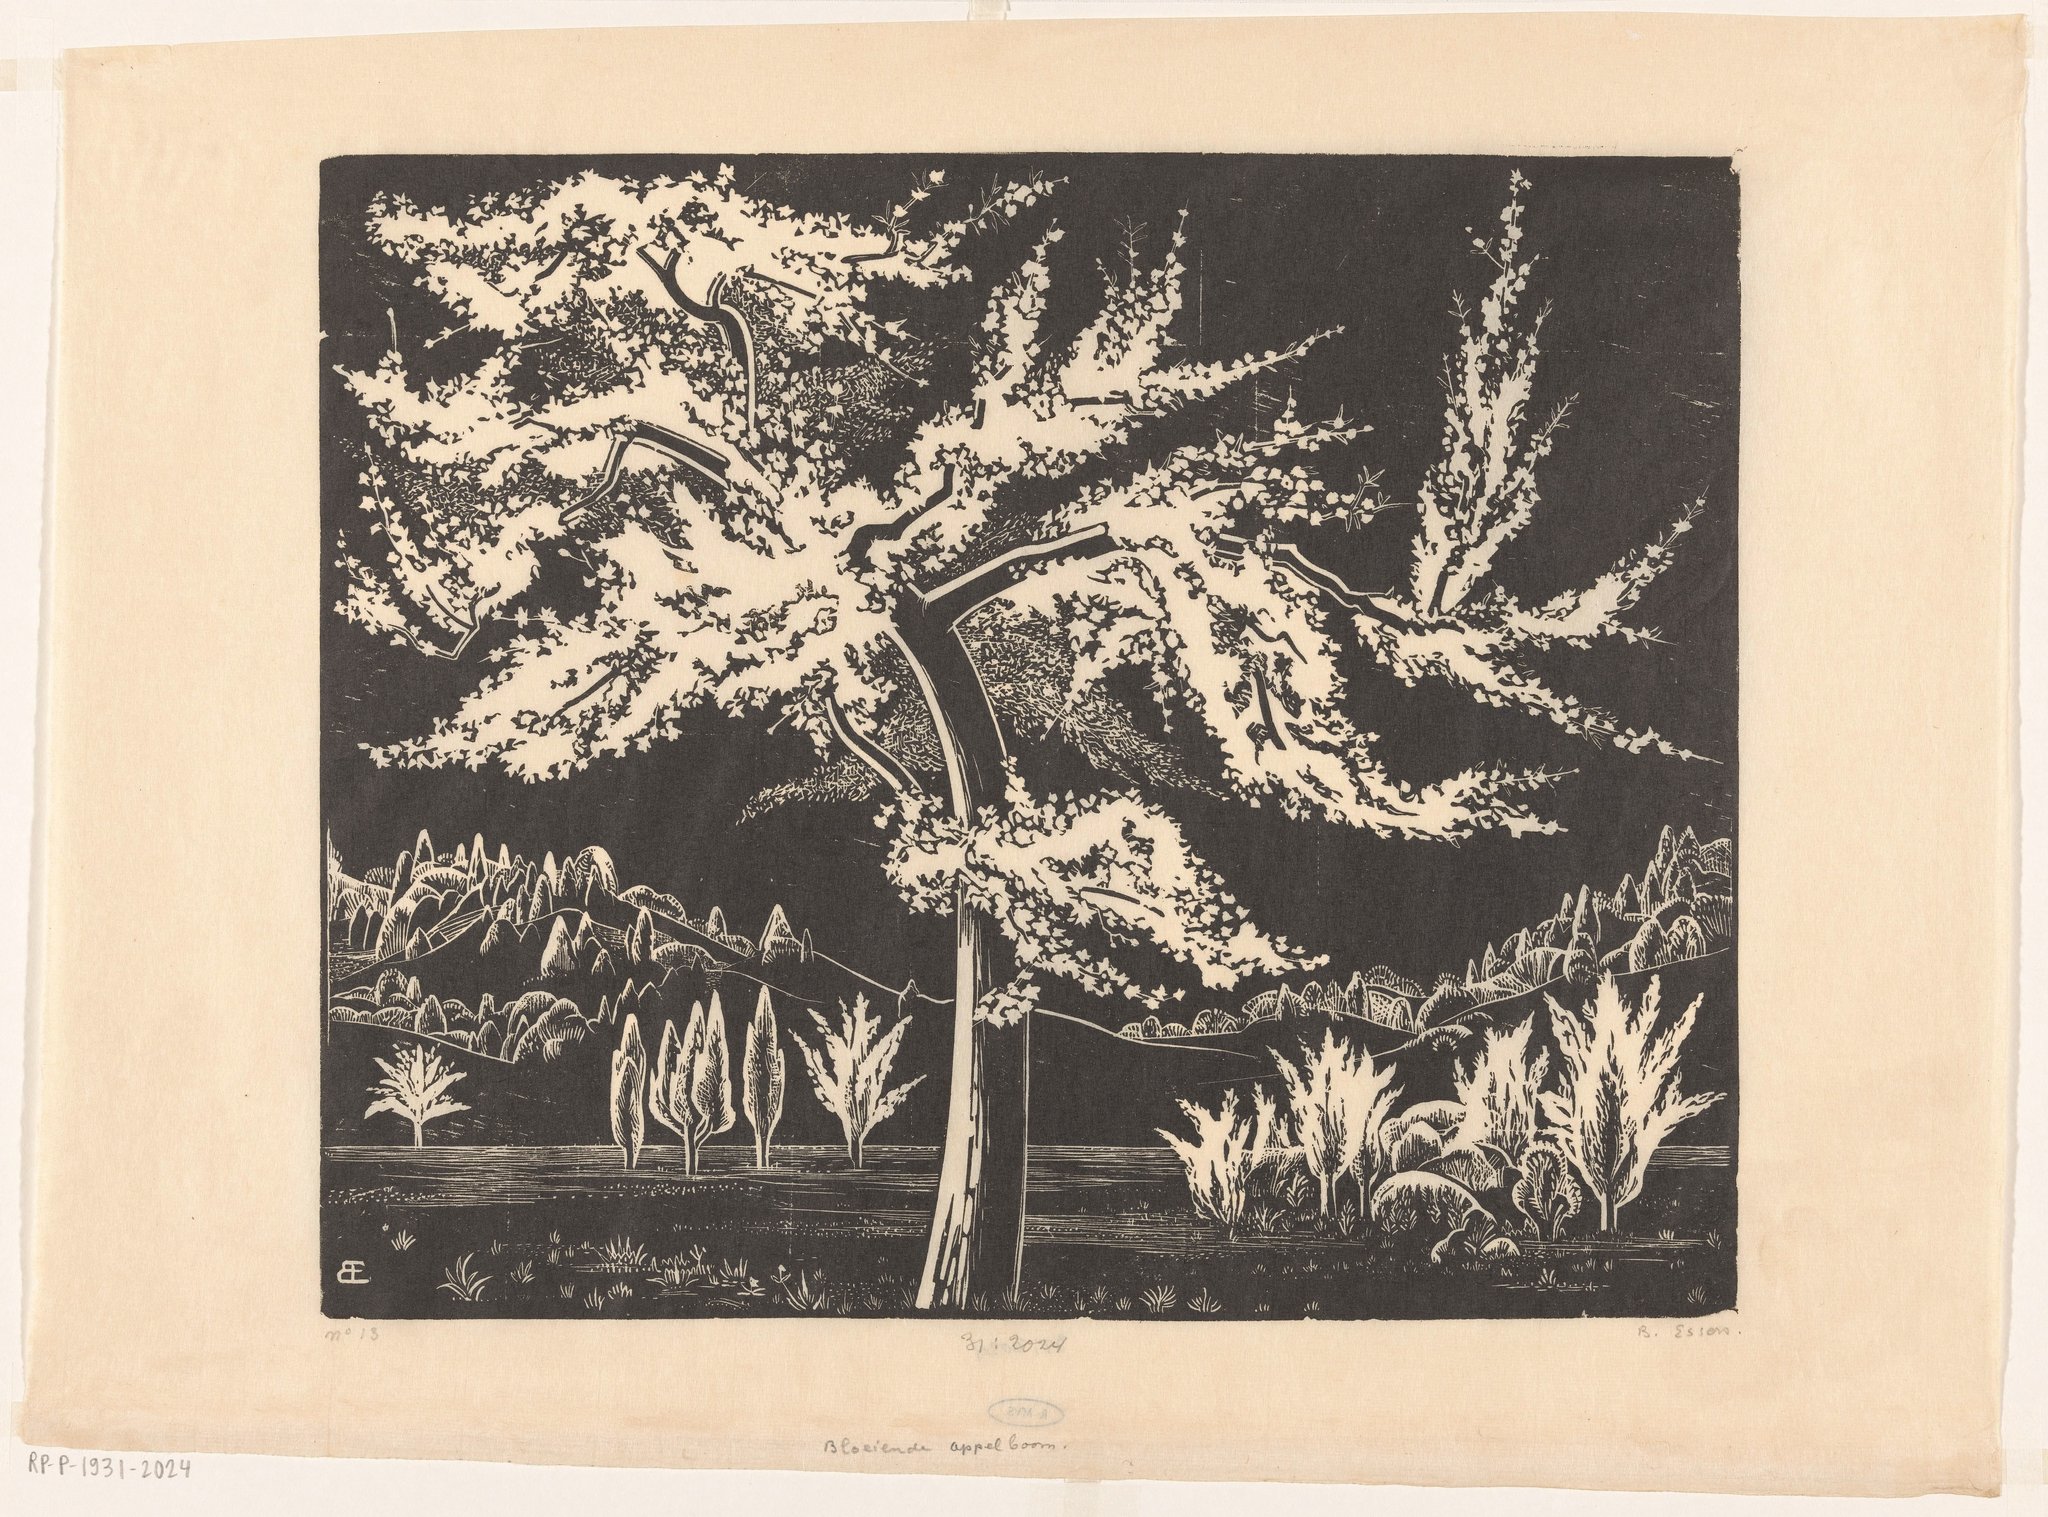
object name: print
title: Bloeiende appelboom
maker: bernard essers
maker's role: print maker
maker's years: 1893-1945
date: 1931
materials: paper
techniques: engraving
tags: low hill country, trees: apple-tree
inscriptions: collector's mark: Lugt 2228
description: Op de achtergrond een heuvellandschap met bomen en struiken.